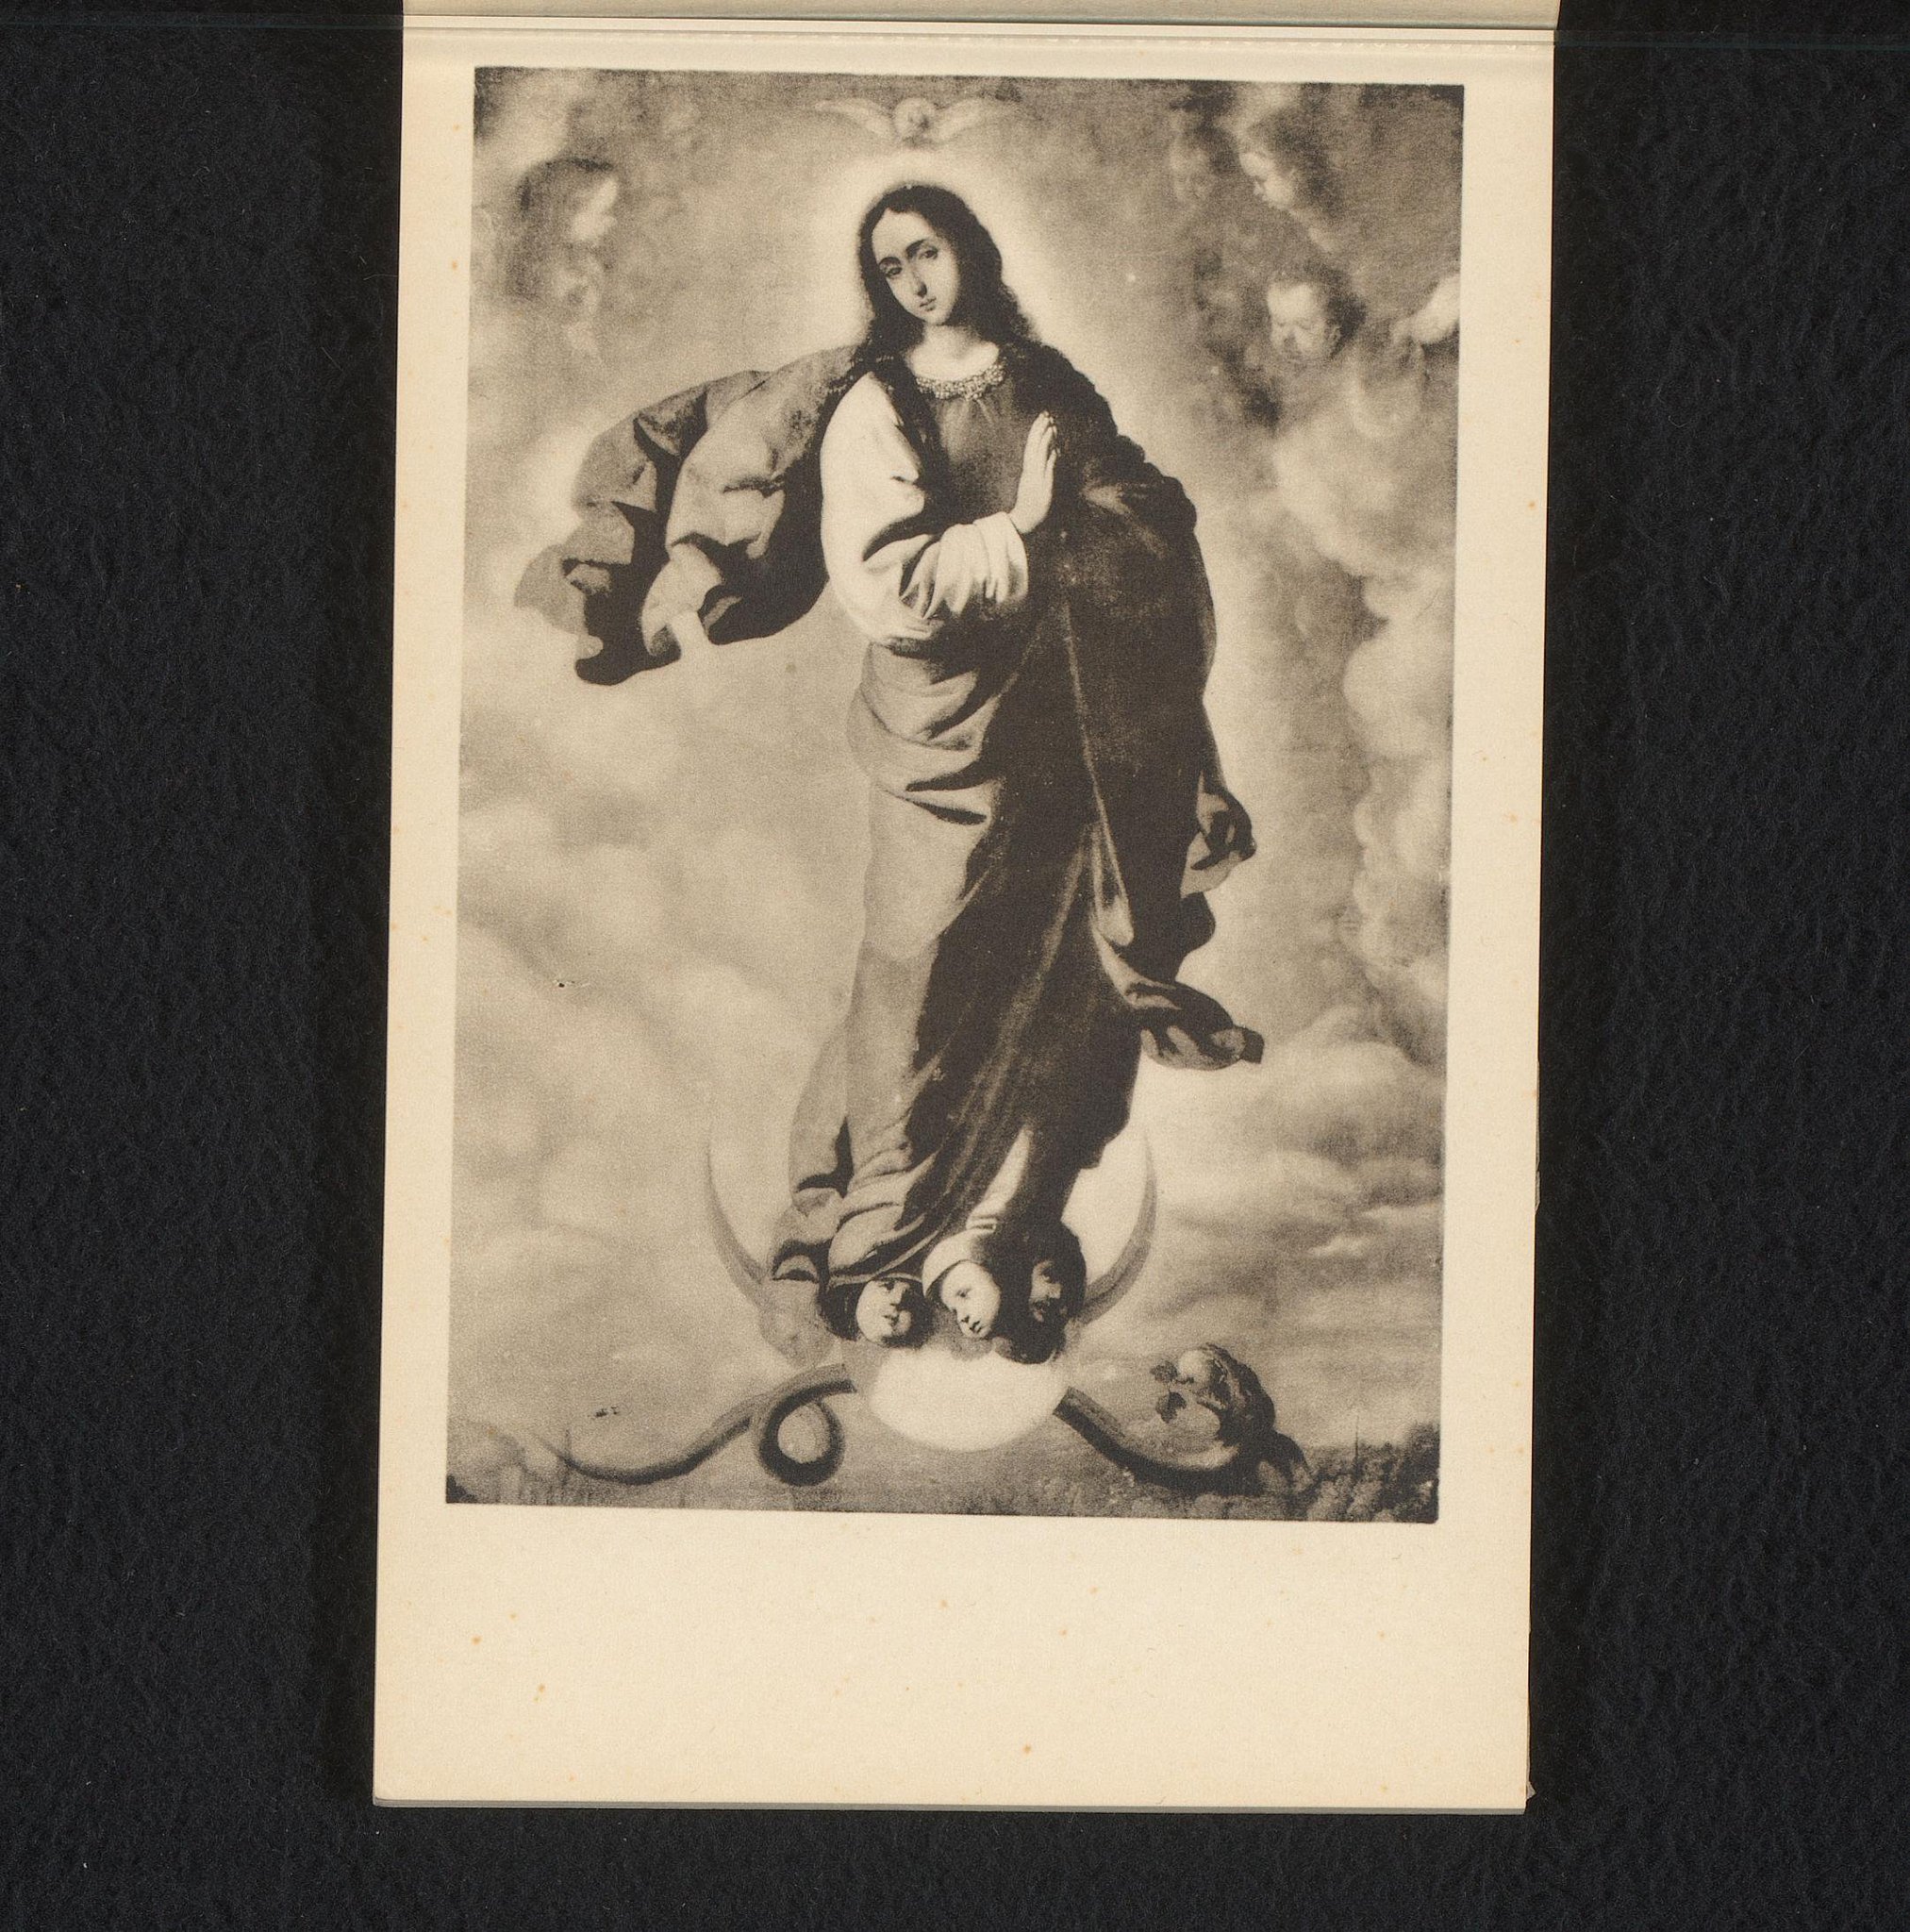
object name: reproduction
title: Museo Cerralbo. Madrid. La Purisima Concepción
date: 1924-1930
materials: cardboard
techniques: photograph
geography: madrid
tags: permanent exhibition, museum, picture, painting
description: Prentbriefkaart maakt deel uit van een album.